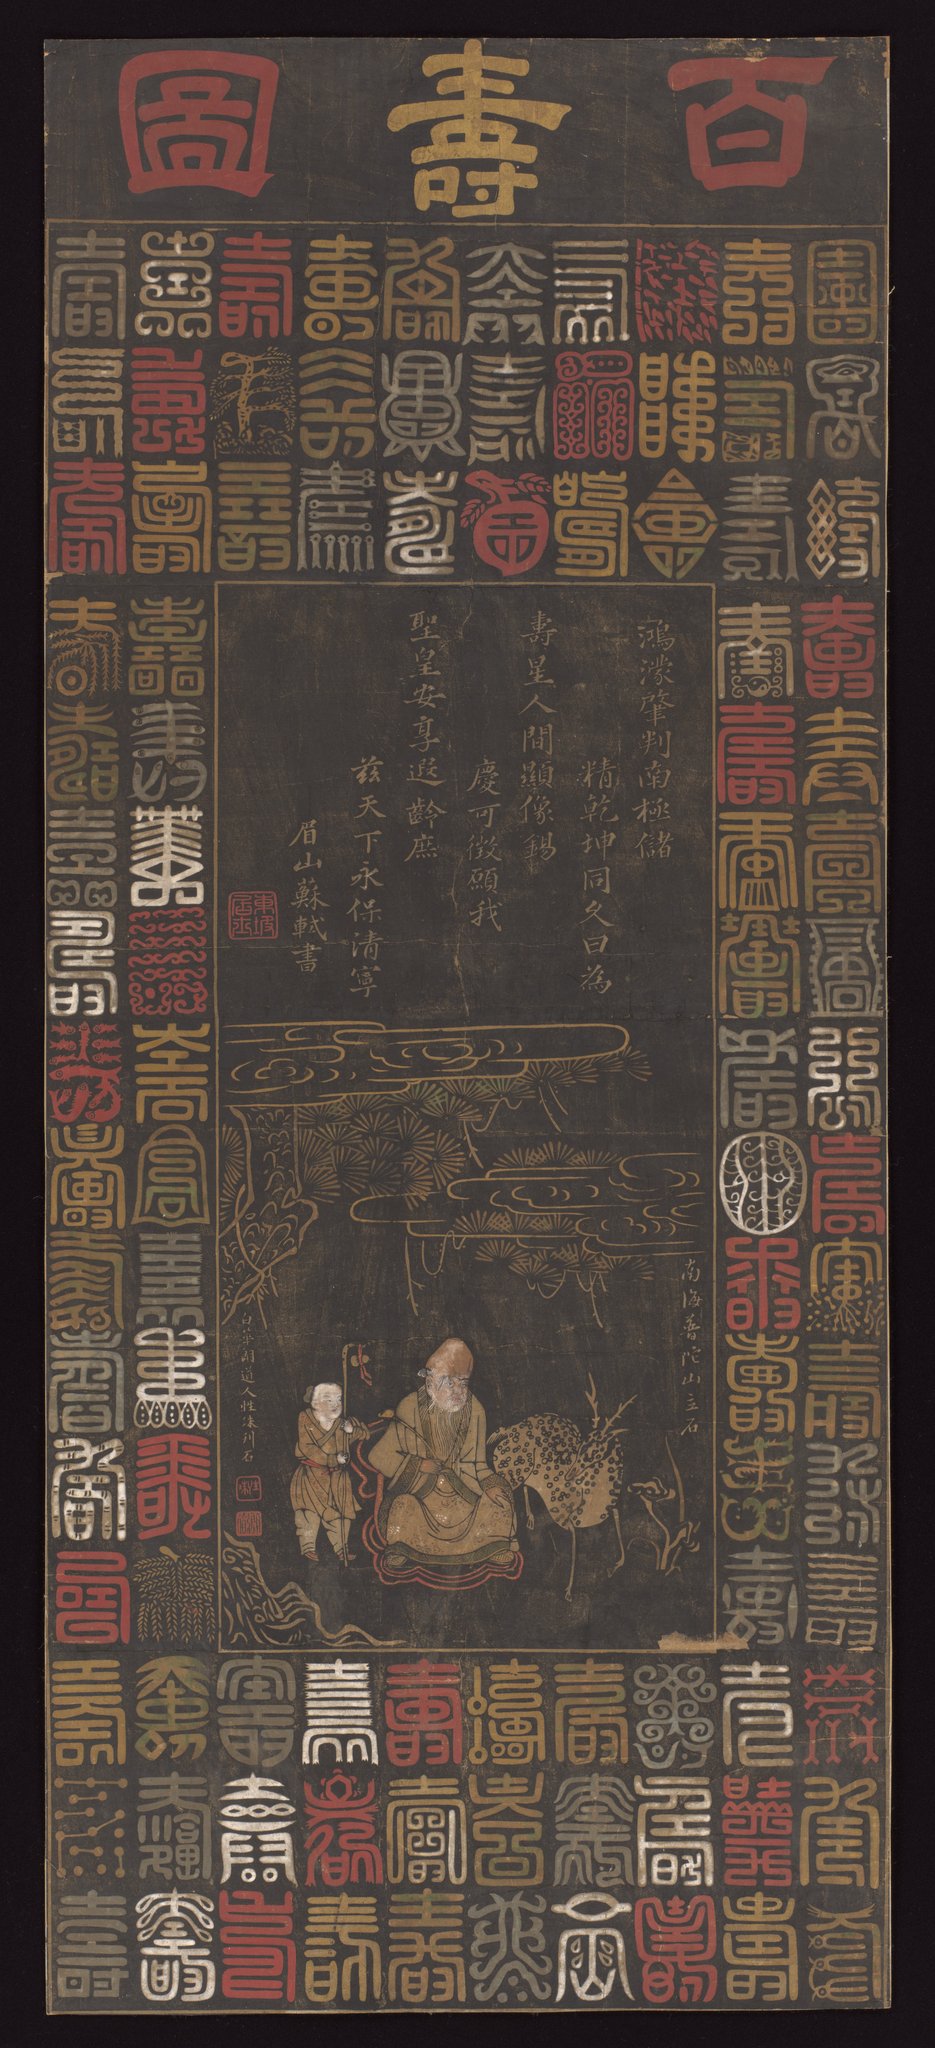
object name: print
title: One Hundred Longevity Characters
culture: chinese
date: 1368-1644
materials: ink, paper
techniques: woodblock print